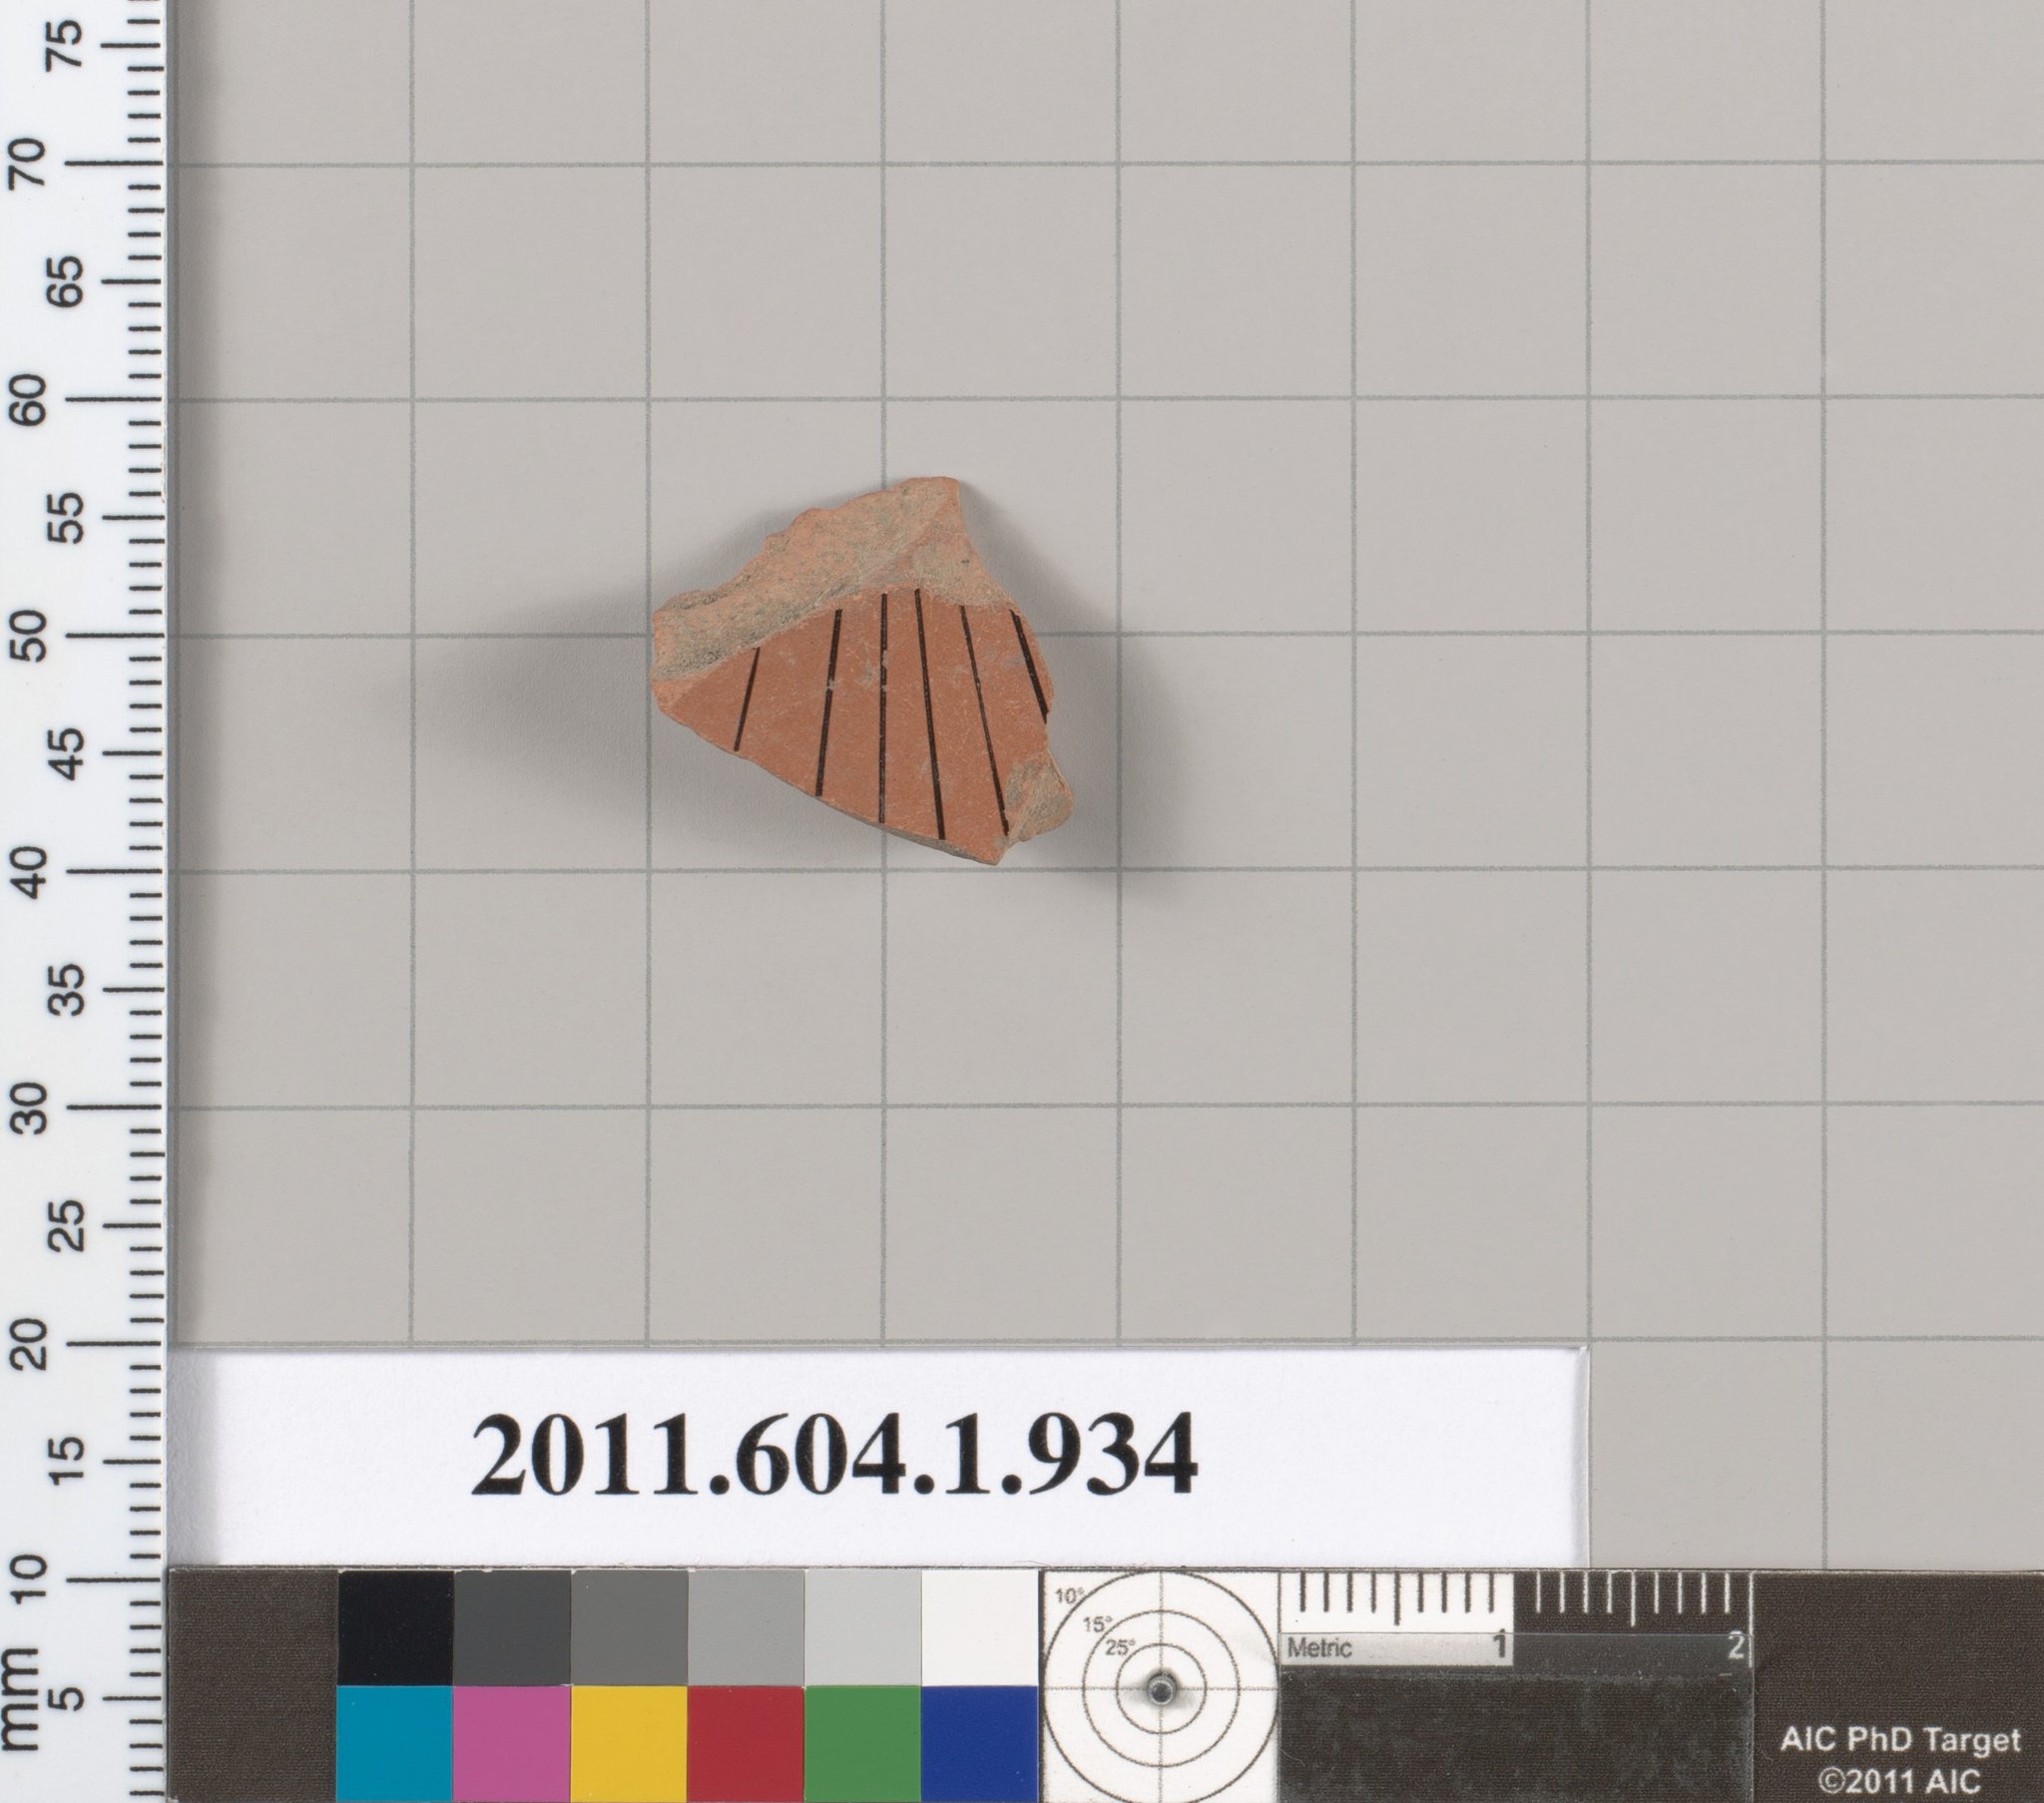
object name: kylix fragment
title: Terracotta fragment of a kylix (drinking cup)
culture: greek, attic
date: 490-480 BCE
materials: terracotta